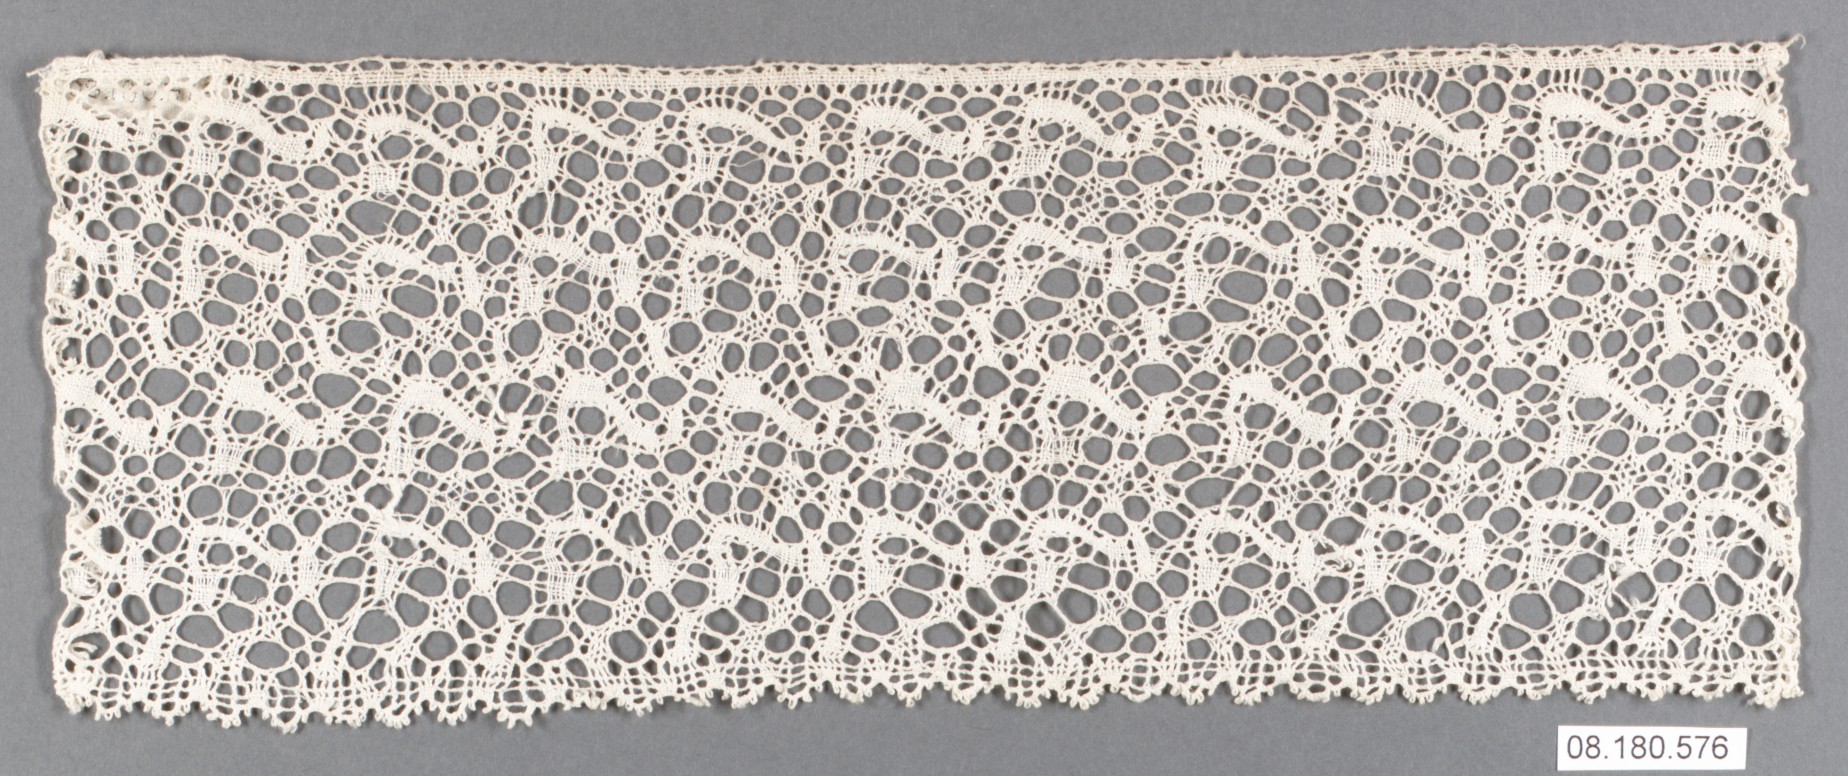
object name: piece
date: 1801-1900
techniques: lace